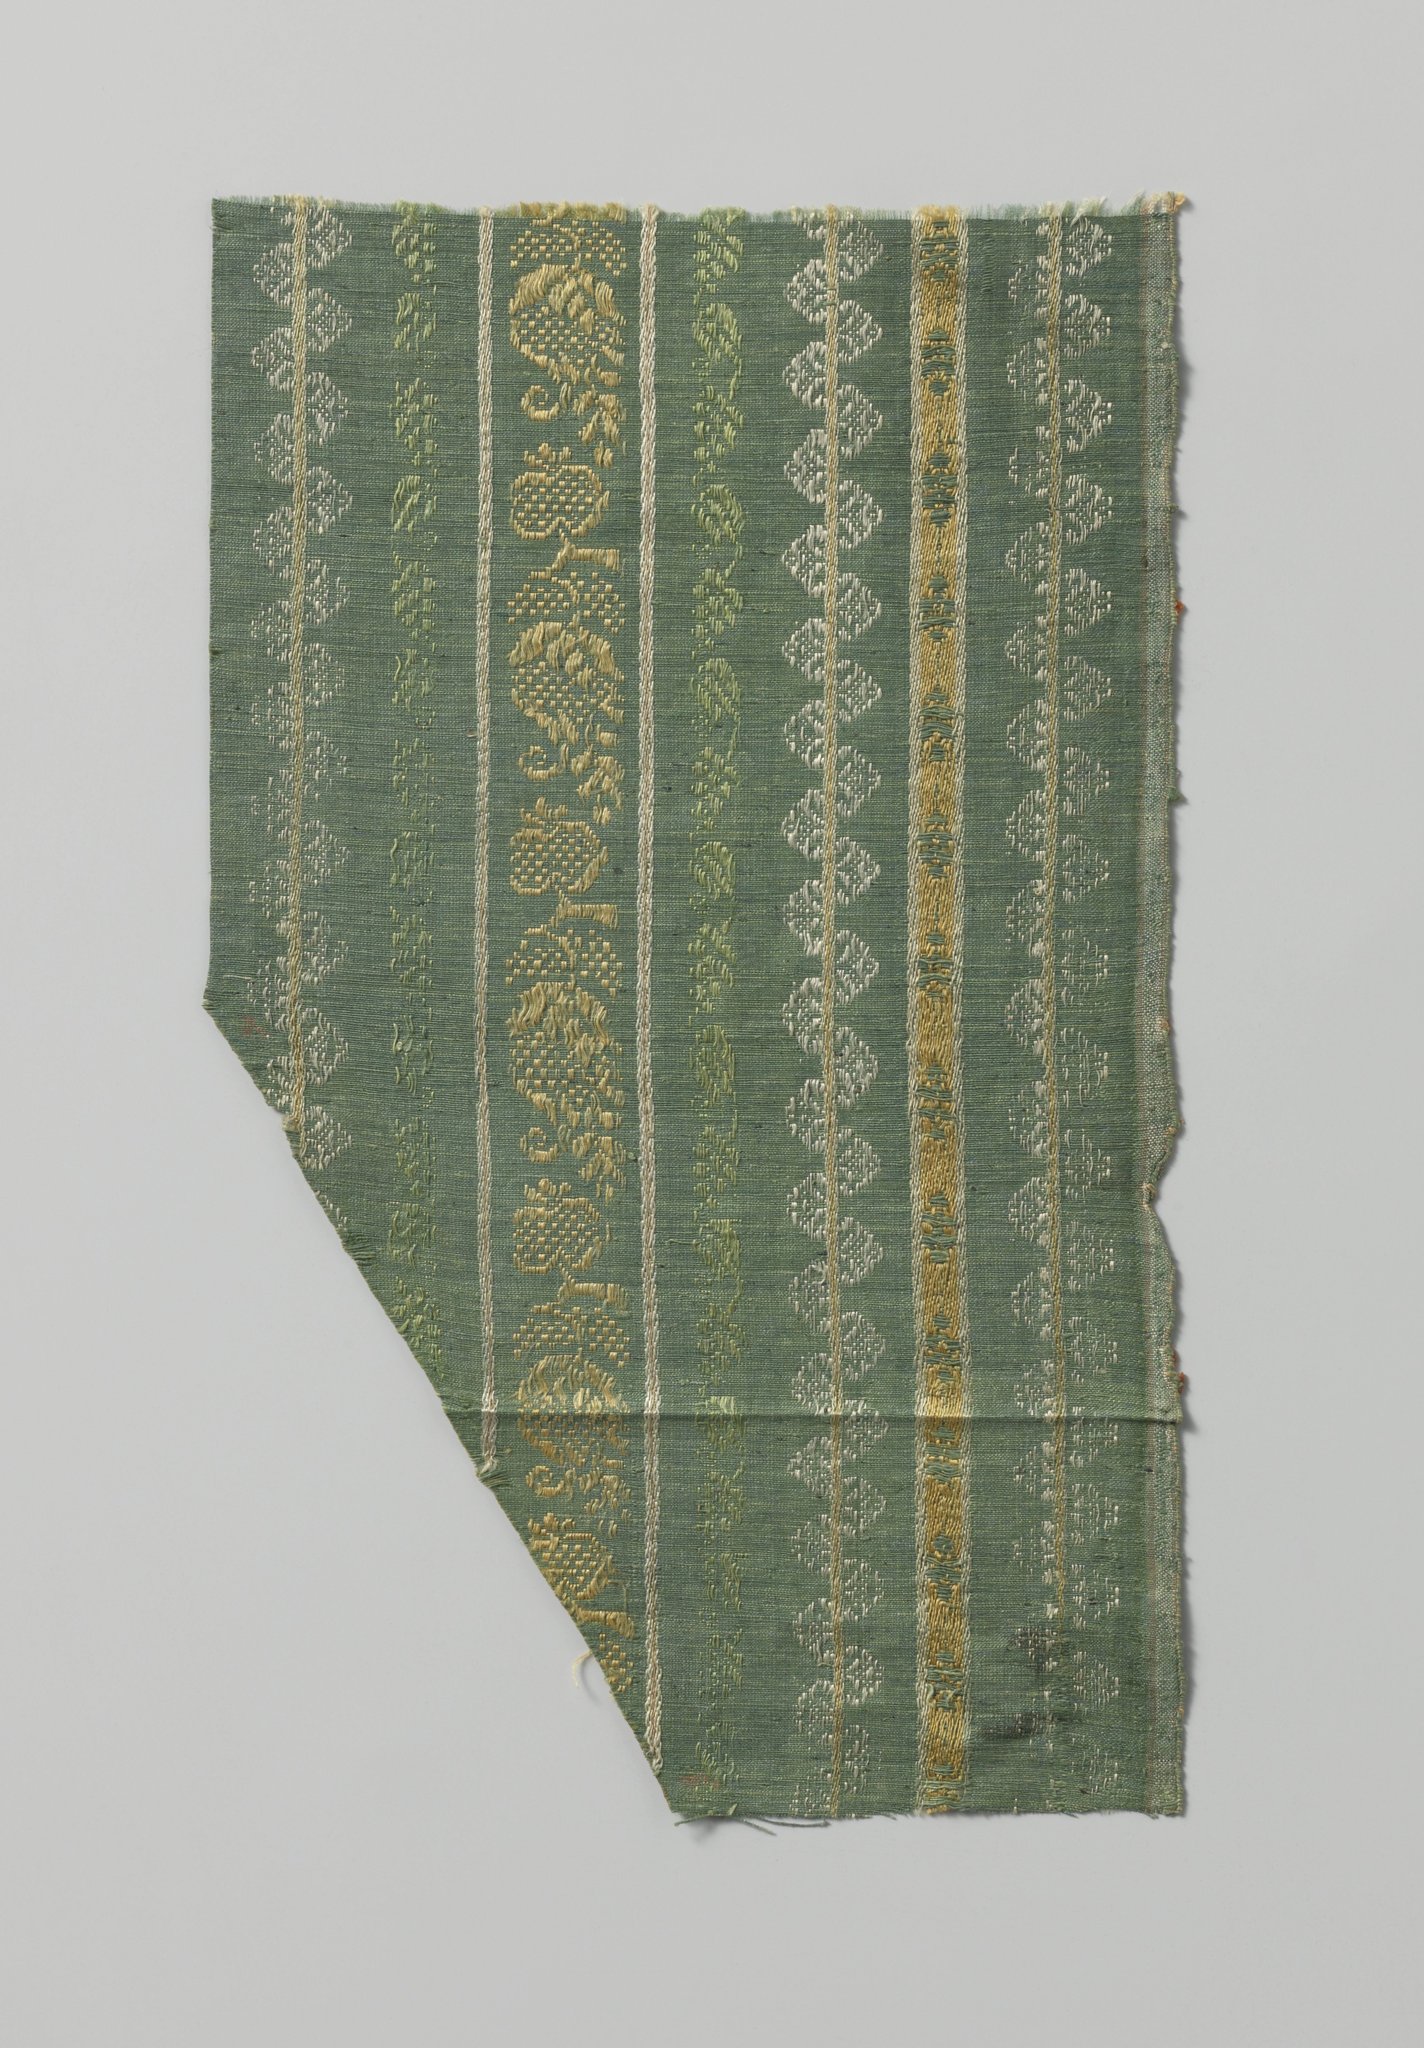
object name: silk textile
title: Fragment zijdeweefsel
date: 1740-1760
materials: linen, silk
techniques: pattern warp, weave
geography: turkey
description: Fragment van groene zijde met verticale strepen in geel, wit en rose, waartussen palmetten, wingerdbladeren en slingerende ranken in wit, geel en lichtgroen.